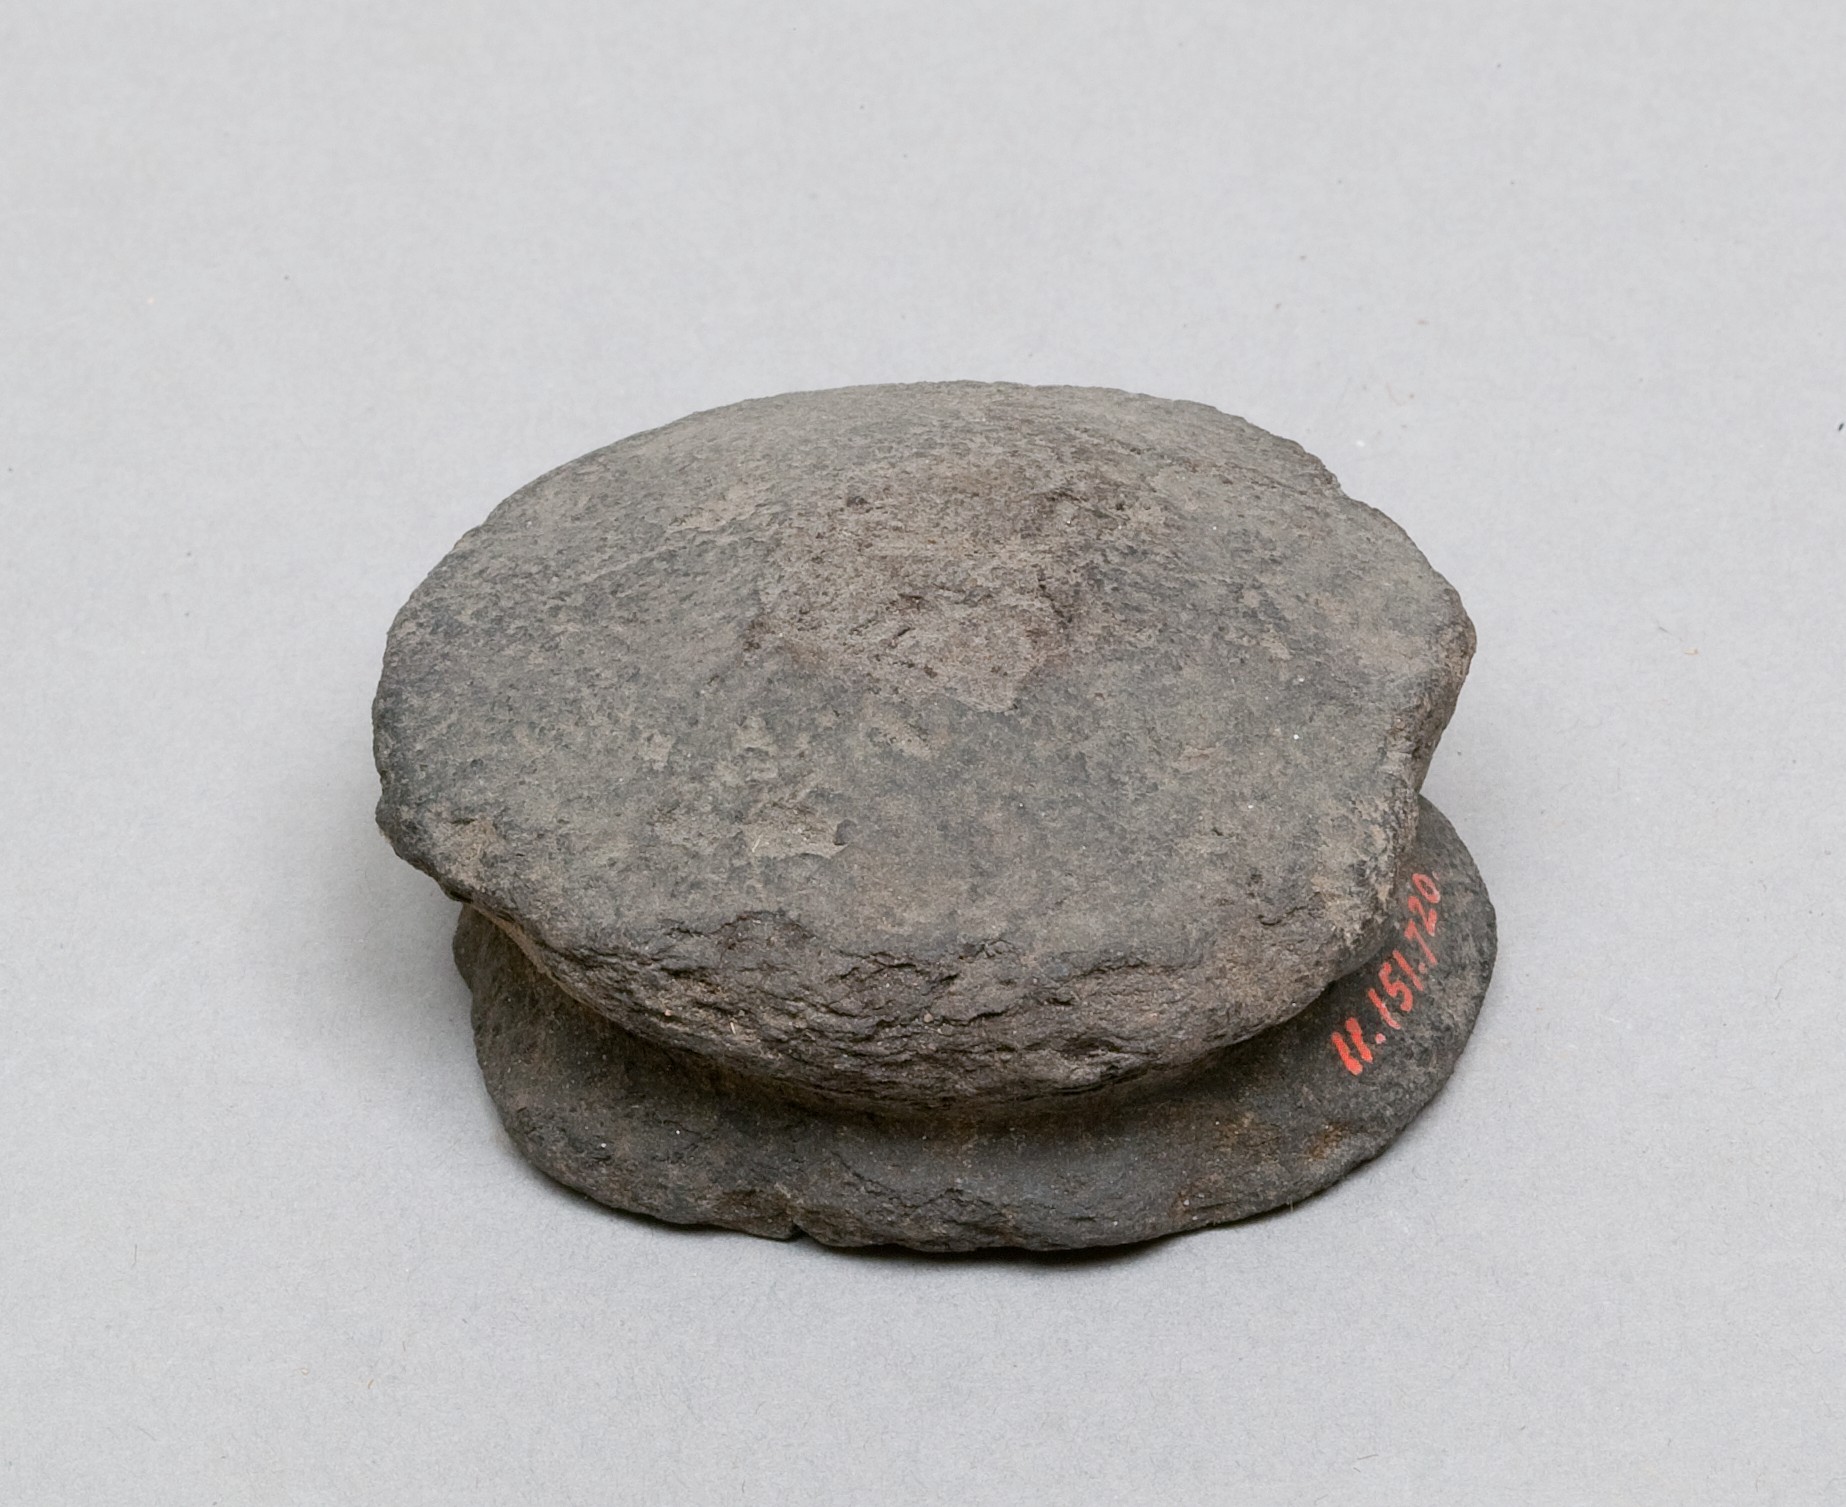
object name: reel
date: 1295-1070 BCE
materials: clay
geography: egypt